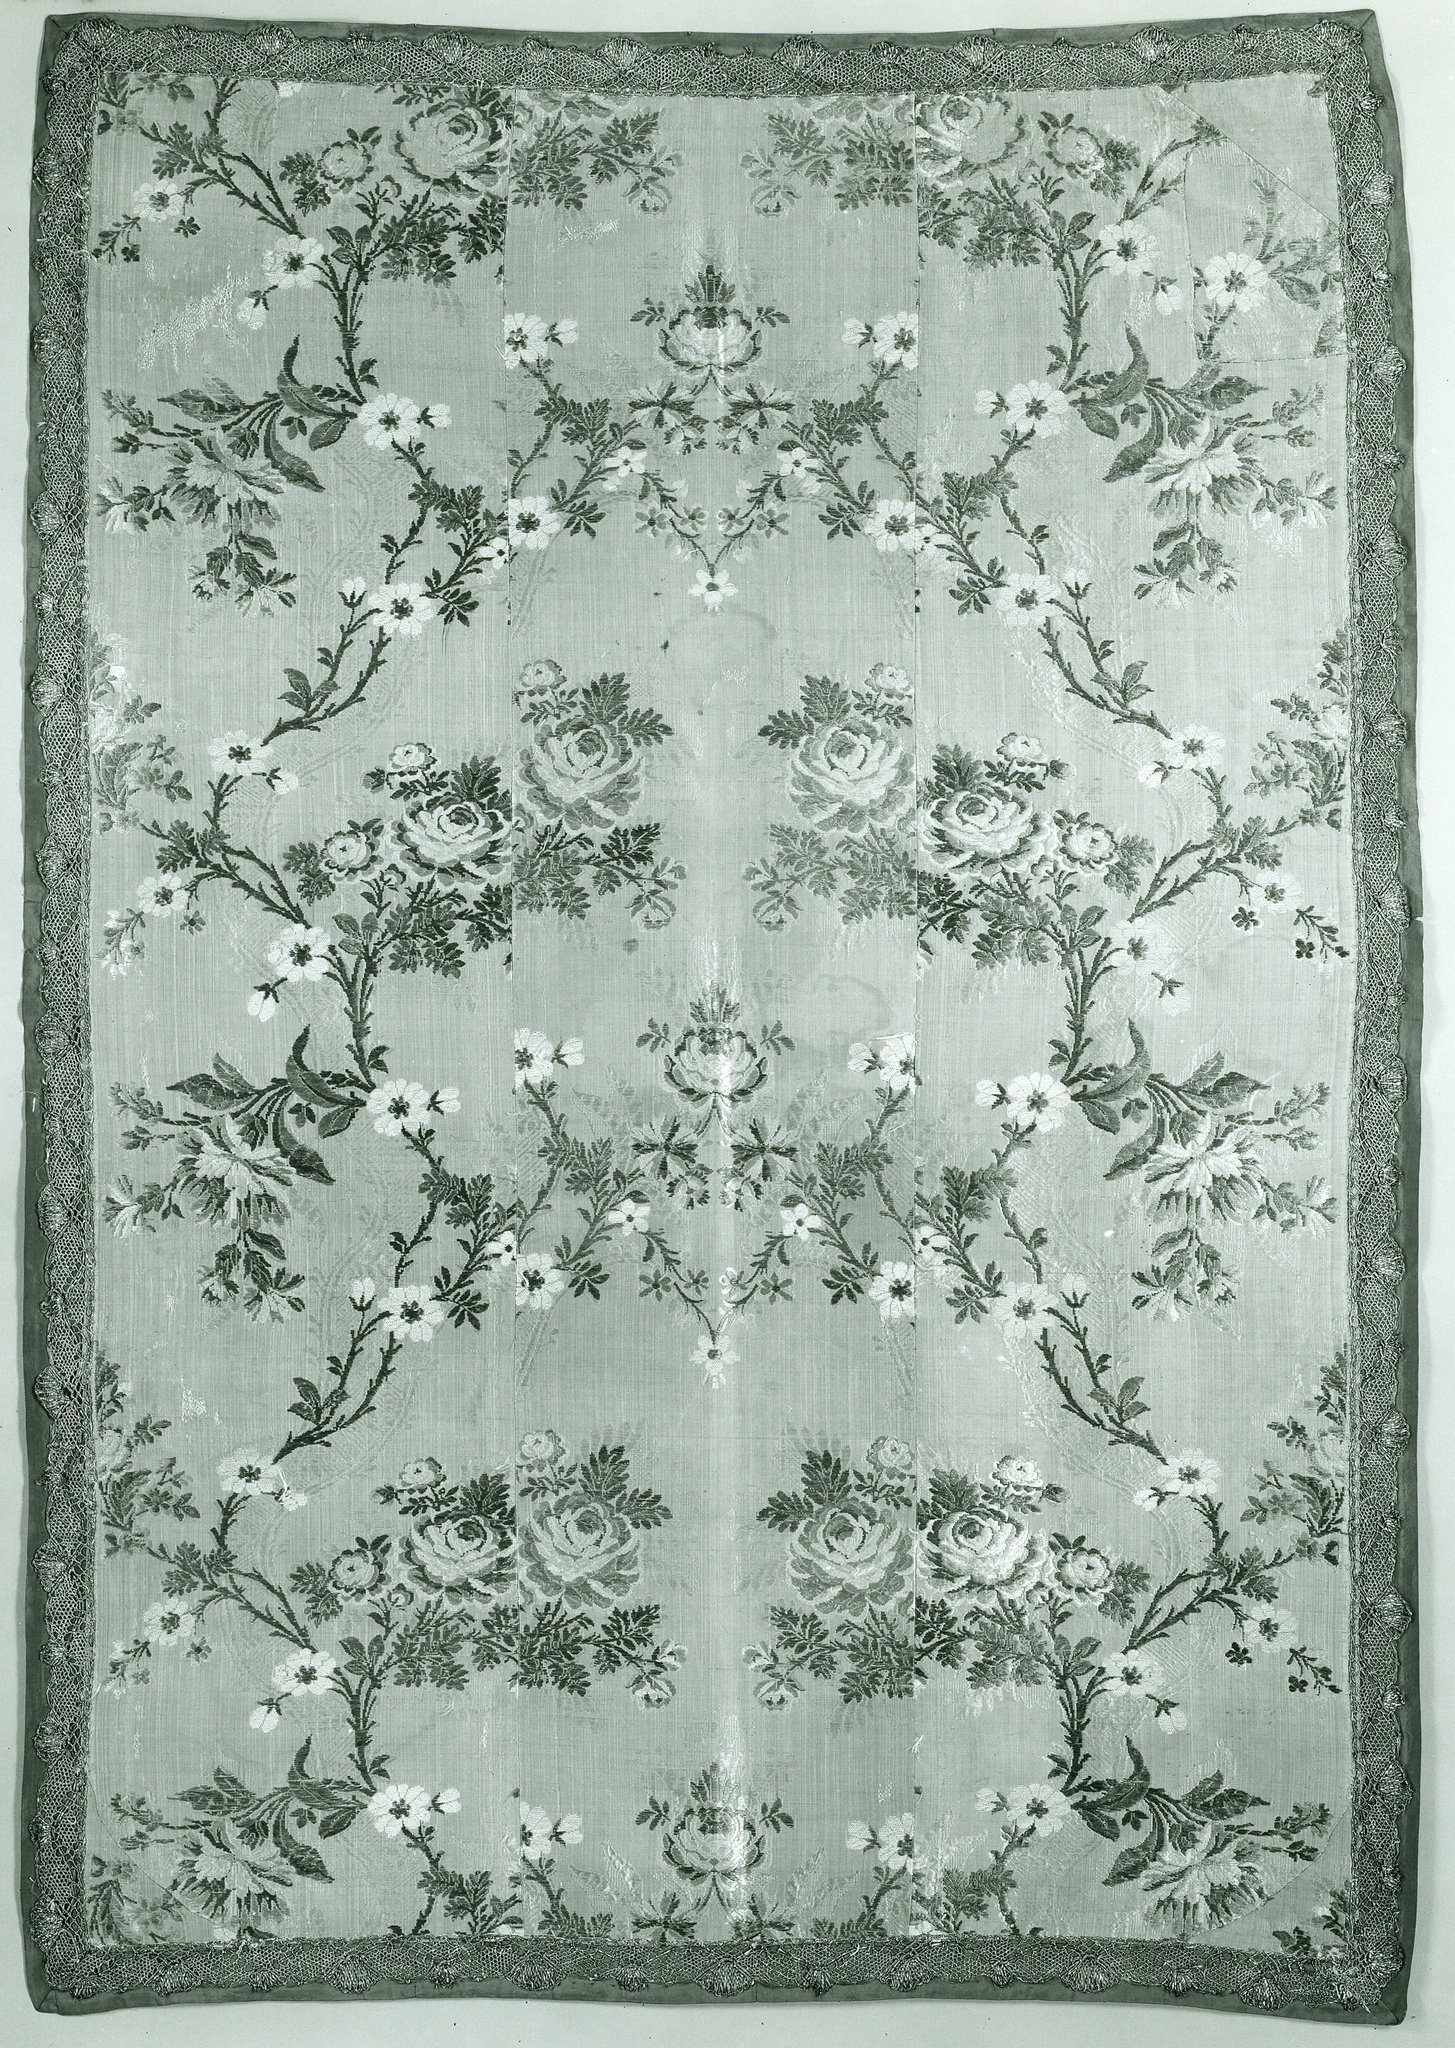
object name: textile cover or hanging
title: Cover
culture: french or spanish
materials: silk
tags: roses